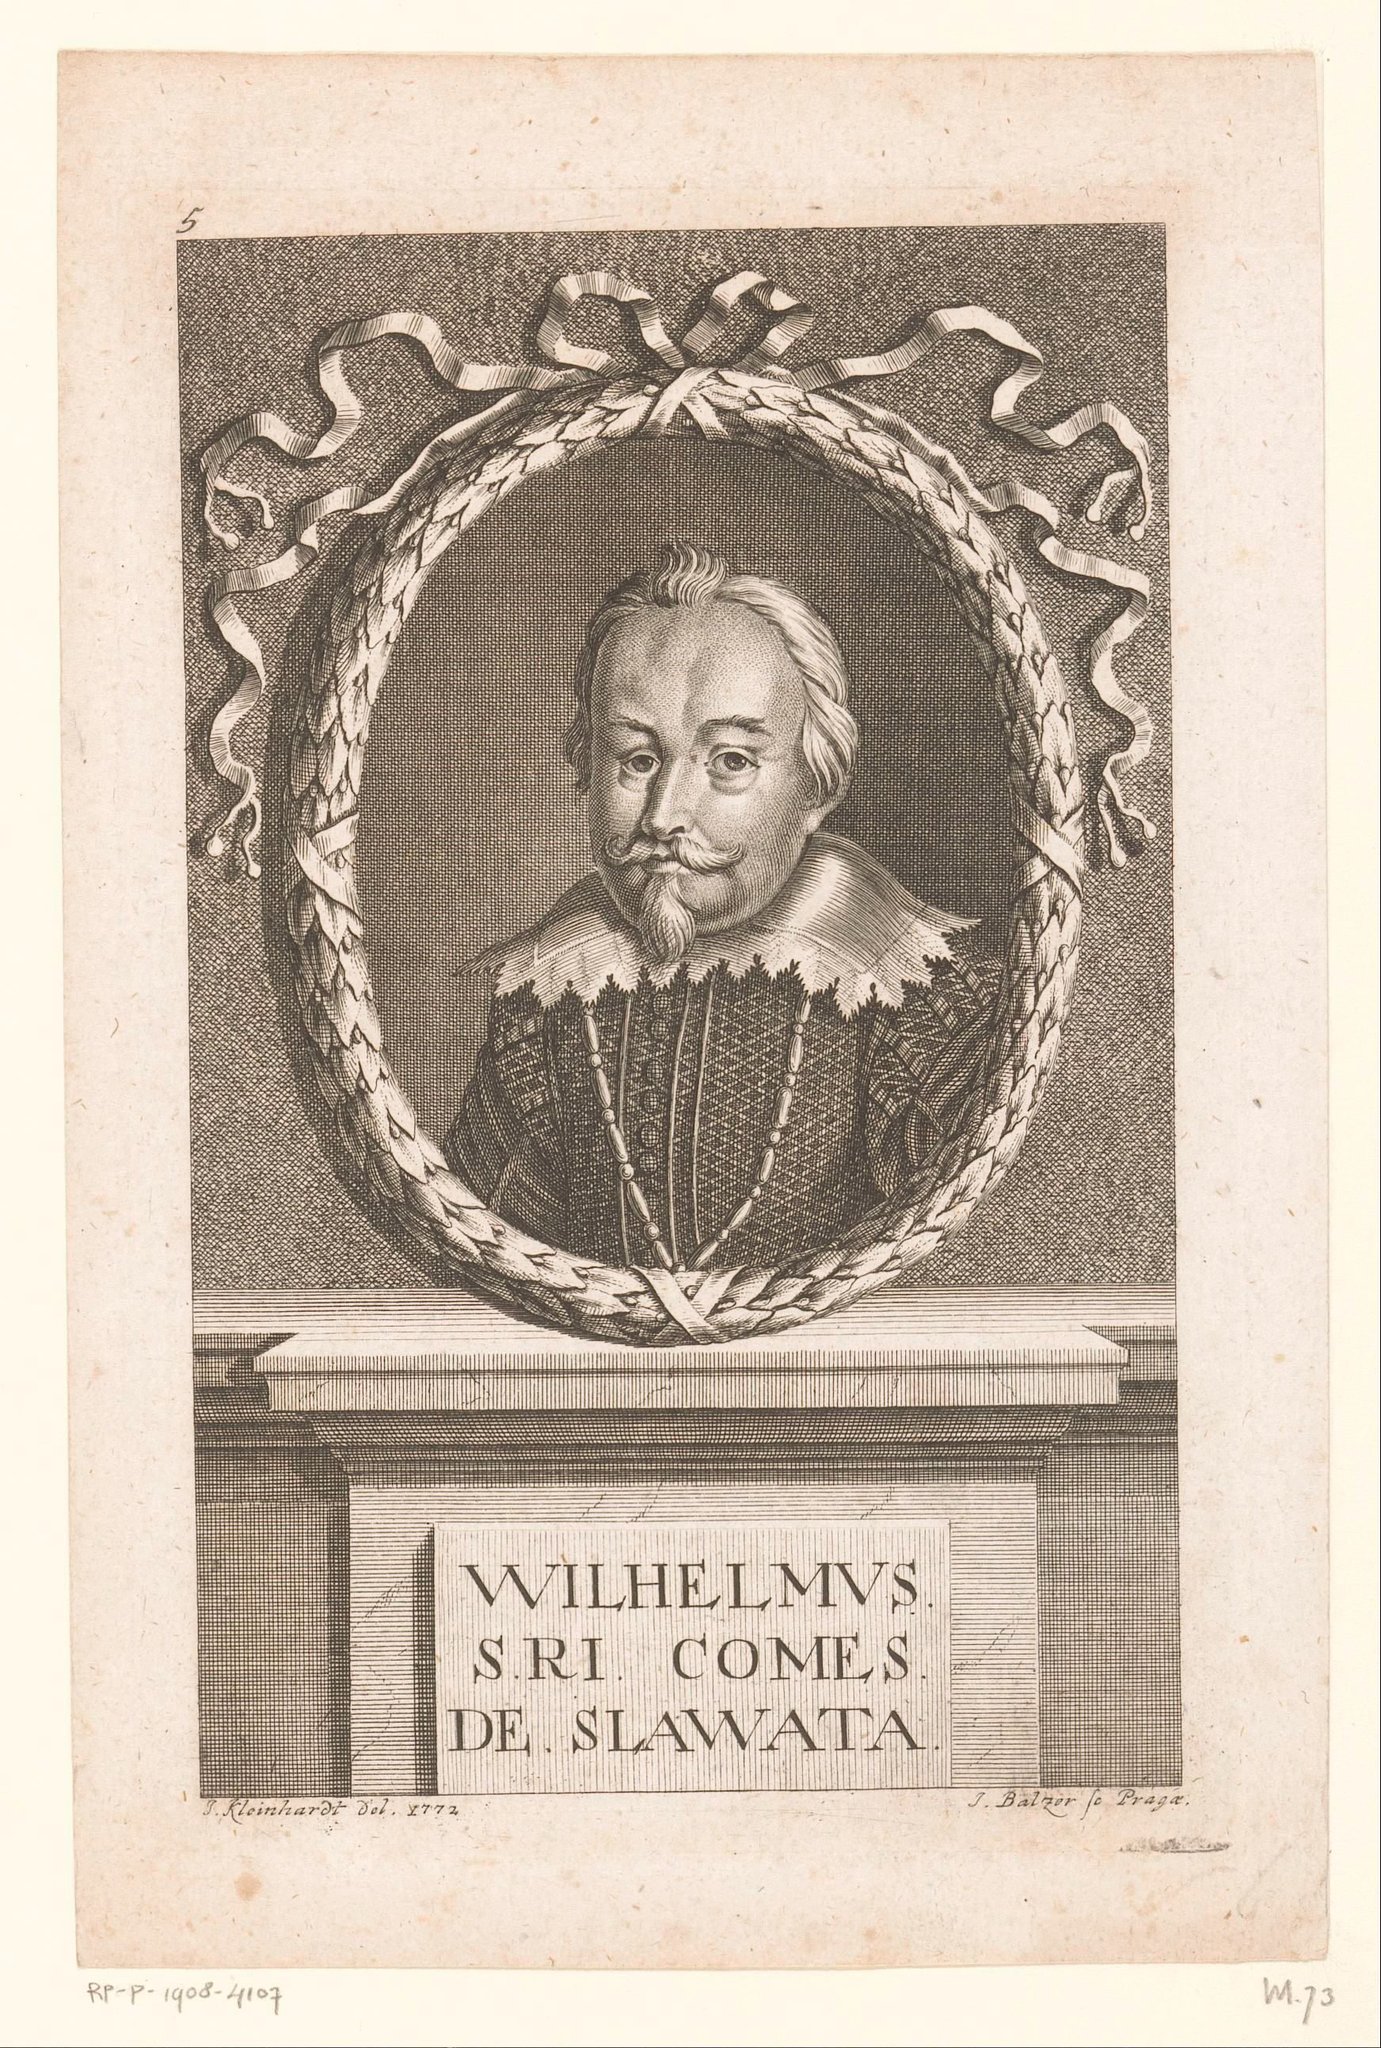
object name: print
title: Portret van Wilhelm von Slawata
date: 1772-1799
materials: paper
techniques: engraving, etching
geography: prague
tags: earl, historical persons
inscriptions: collector's mark: Lugt 2228